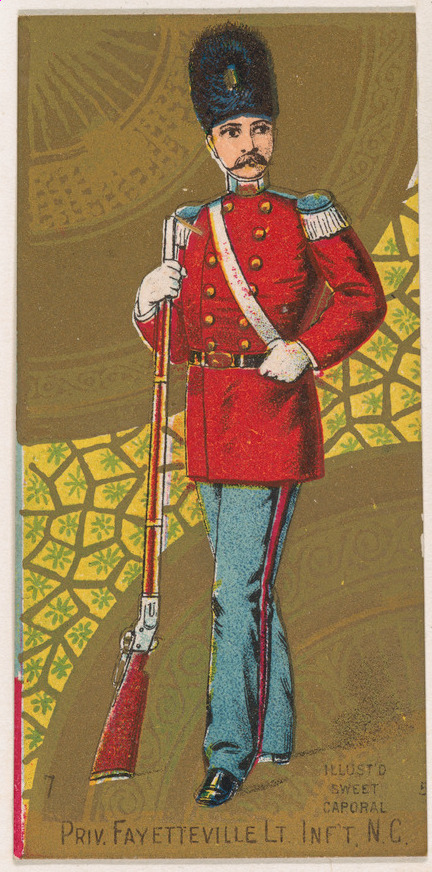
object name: print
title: Private, Fayetteville Light Infantry, North Carolina, from the Military Series (N224) issued by Kinney Tobacco Company to promote Sweet Caporal Cigarettes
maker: kinney brothers tobacco company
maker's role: publisher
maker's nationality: american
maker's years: 1869-2011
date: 1888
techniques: color lithograph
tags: military,firearms,men